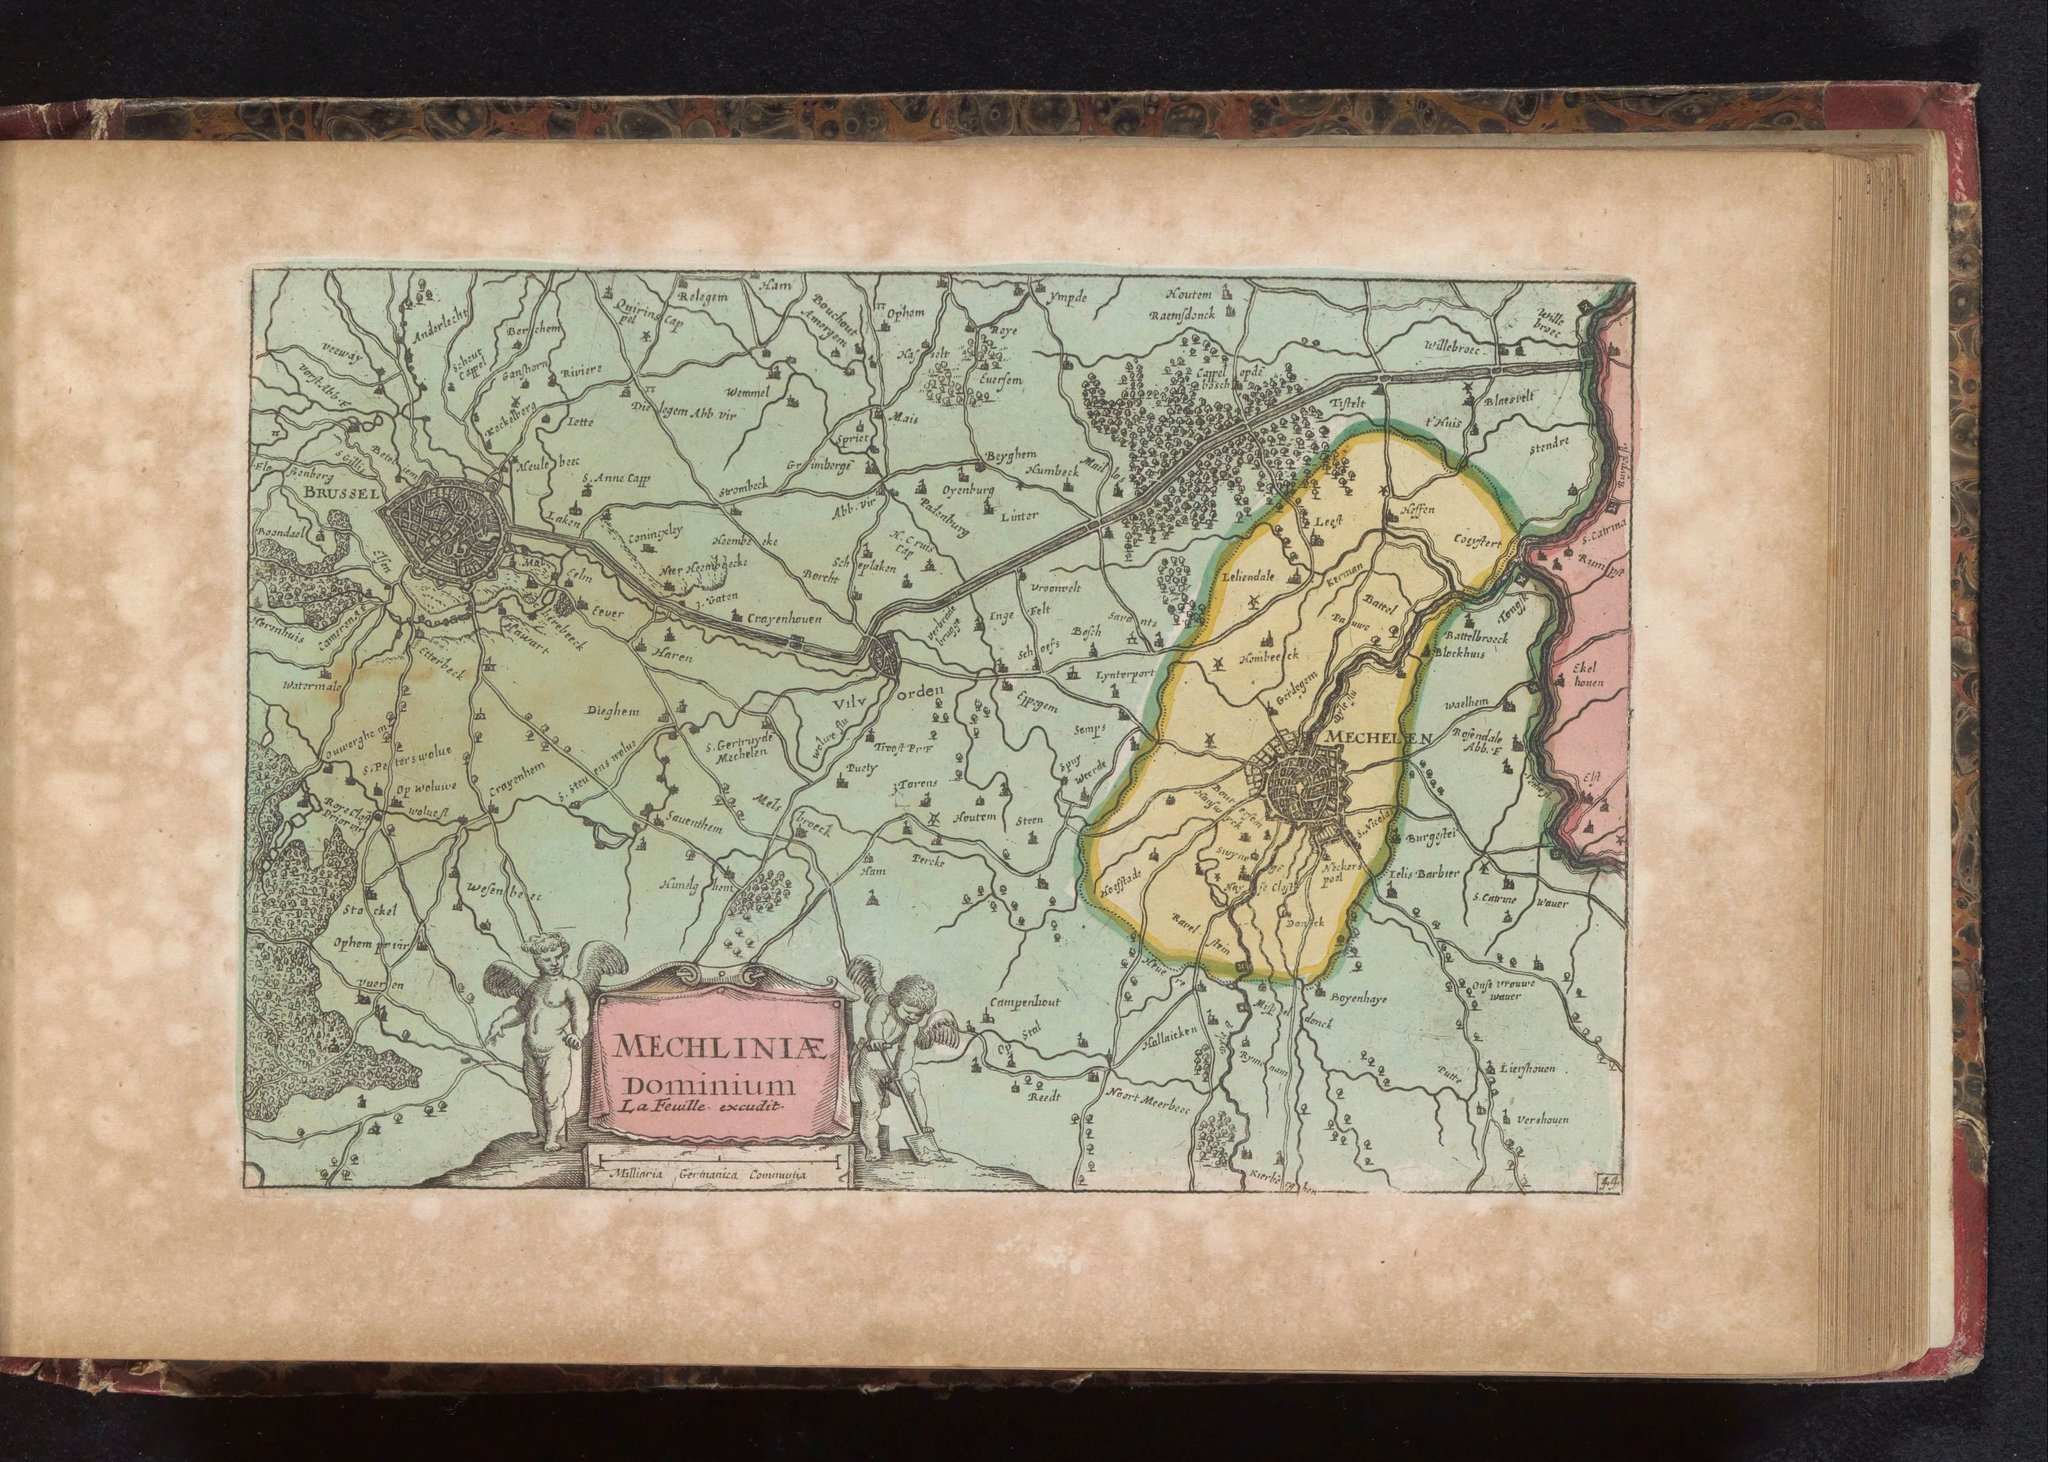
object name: map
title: Kaart van de heerlijkheid Mechelen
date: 1700-1702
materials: paper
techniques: engraving, etching, hand coloring, lacquer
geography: amsterdam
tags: maps of separate countries or regions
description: Kaart van de heerlijkheid Mechelen. Onderdeel van een atlas met 223 kaarten van landen en steden en oorlogstaferelen in Europa in de periode ca. 1690-1735.